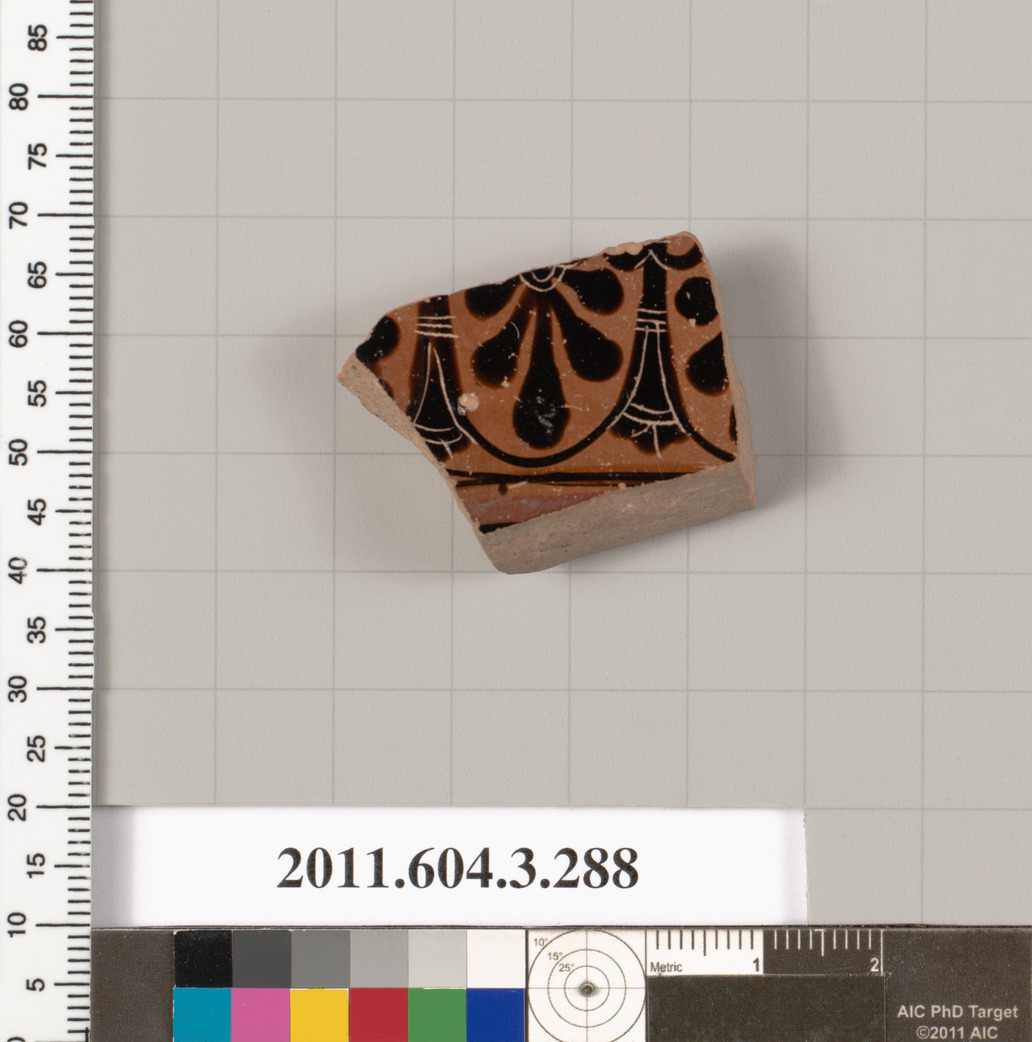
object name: neck amphora fragment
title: Terracotta fragment of a neck-amphora (jar)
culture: greek, attic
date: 530-520 BCE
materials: terracotta